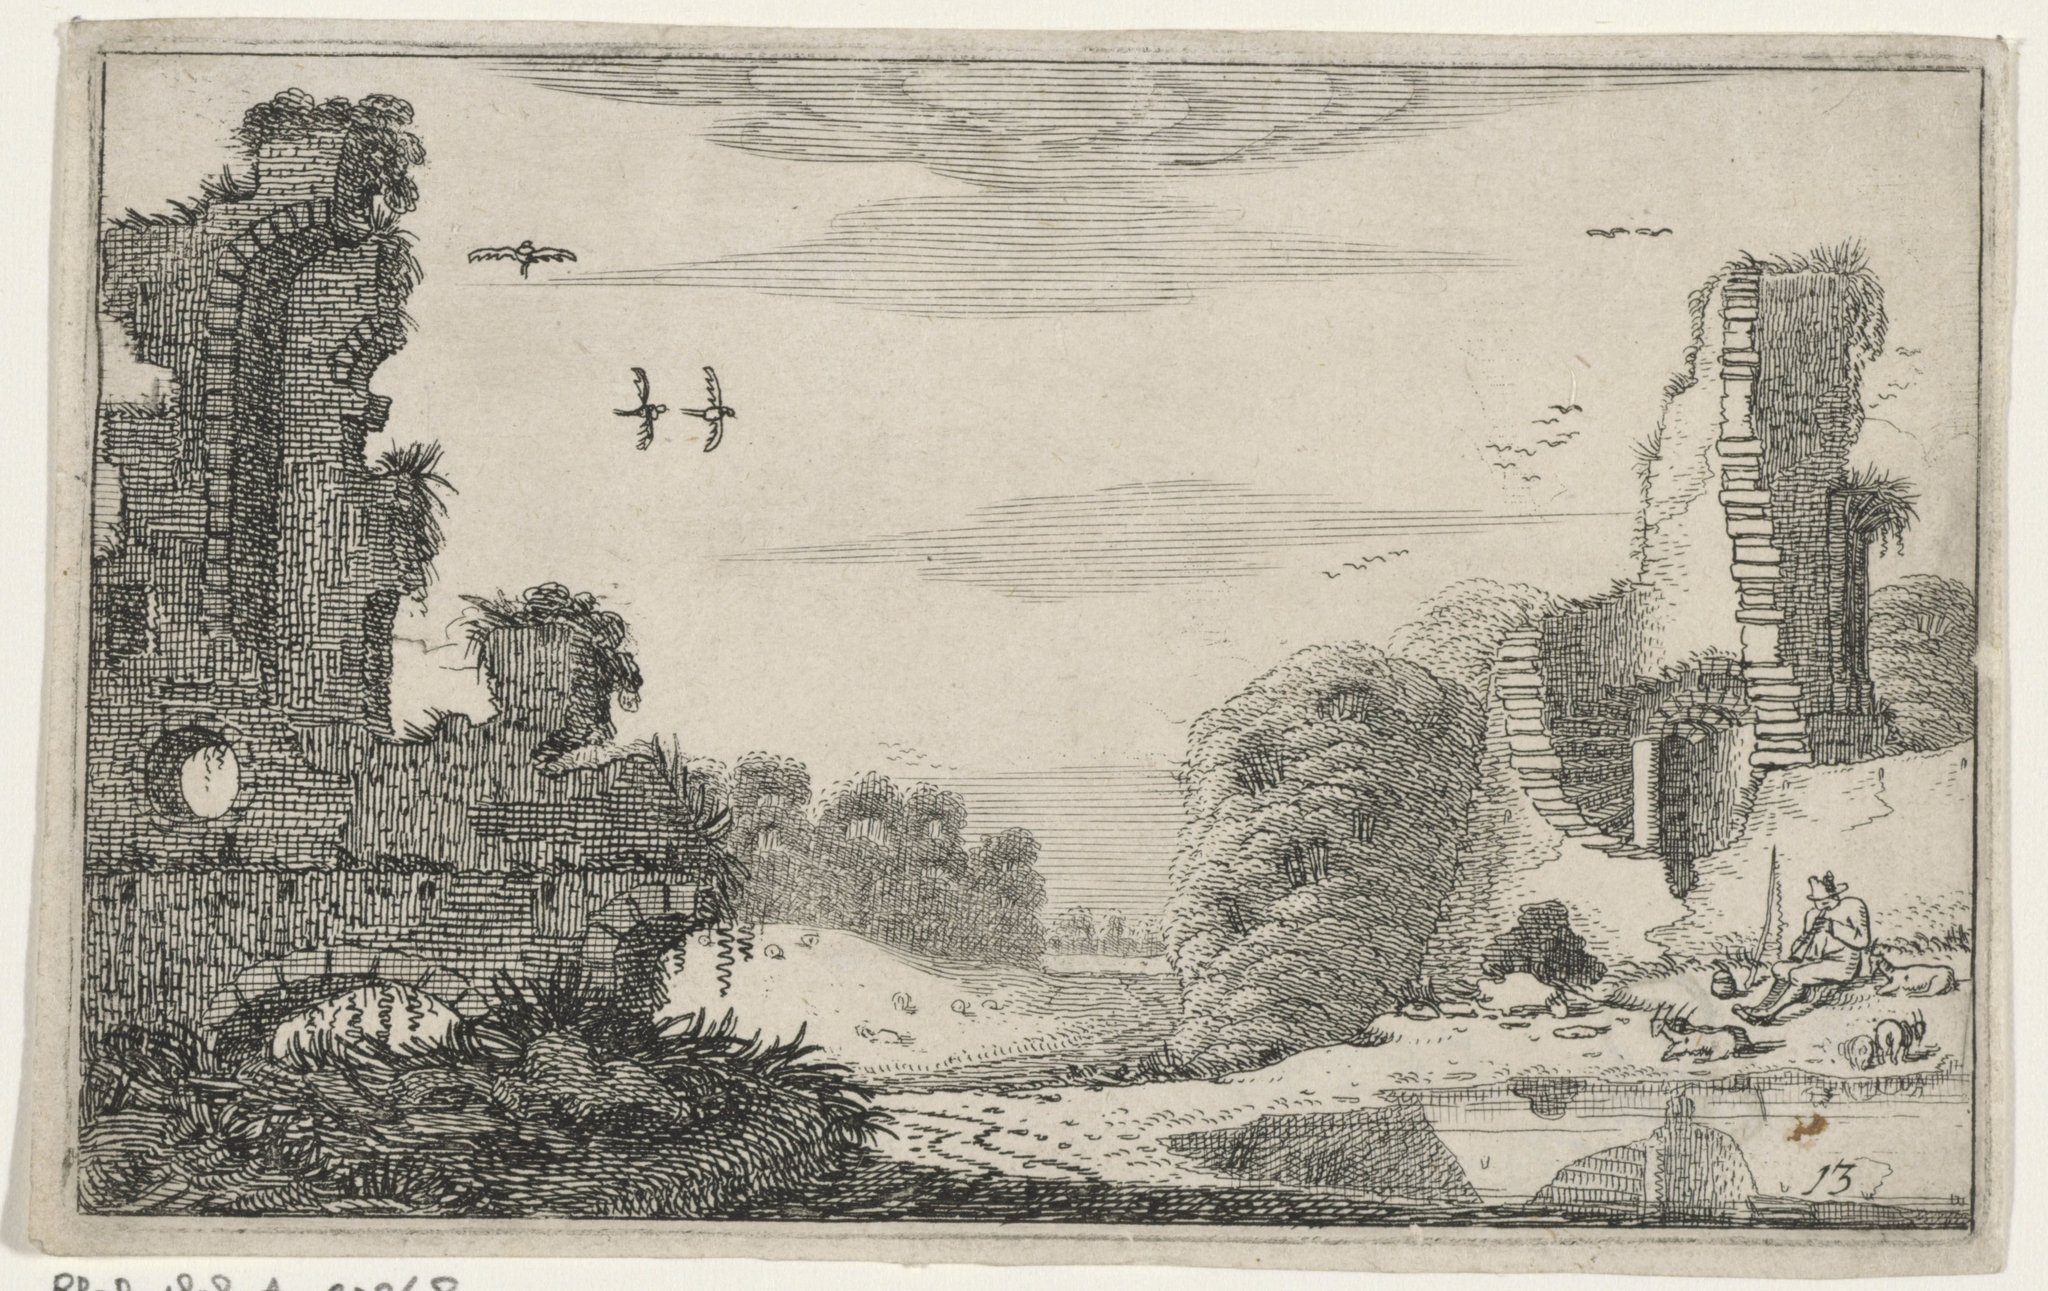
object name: print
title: Ruïnes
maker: jan van de velde (ii)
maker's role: draughtsman, painter, print maker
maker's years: 1593-1641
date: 1616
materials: paper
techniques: engraving, etching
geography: northern netherlands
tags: herding, herdsman, herdswoman, shepherd, shepherdess, cowherd, etc., landscape with ruins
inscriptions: collector's mark: Lugt 964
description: Fluit spelende herder met schapen bij een ruïne in een landschap. Dertiende prent uit een serie van twintig.